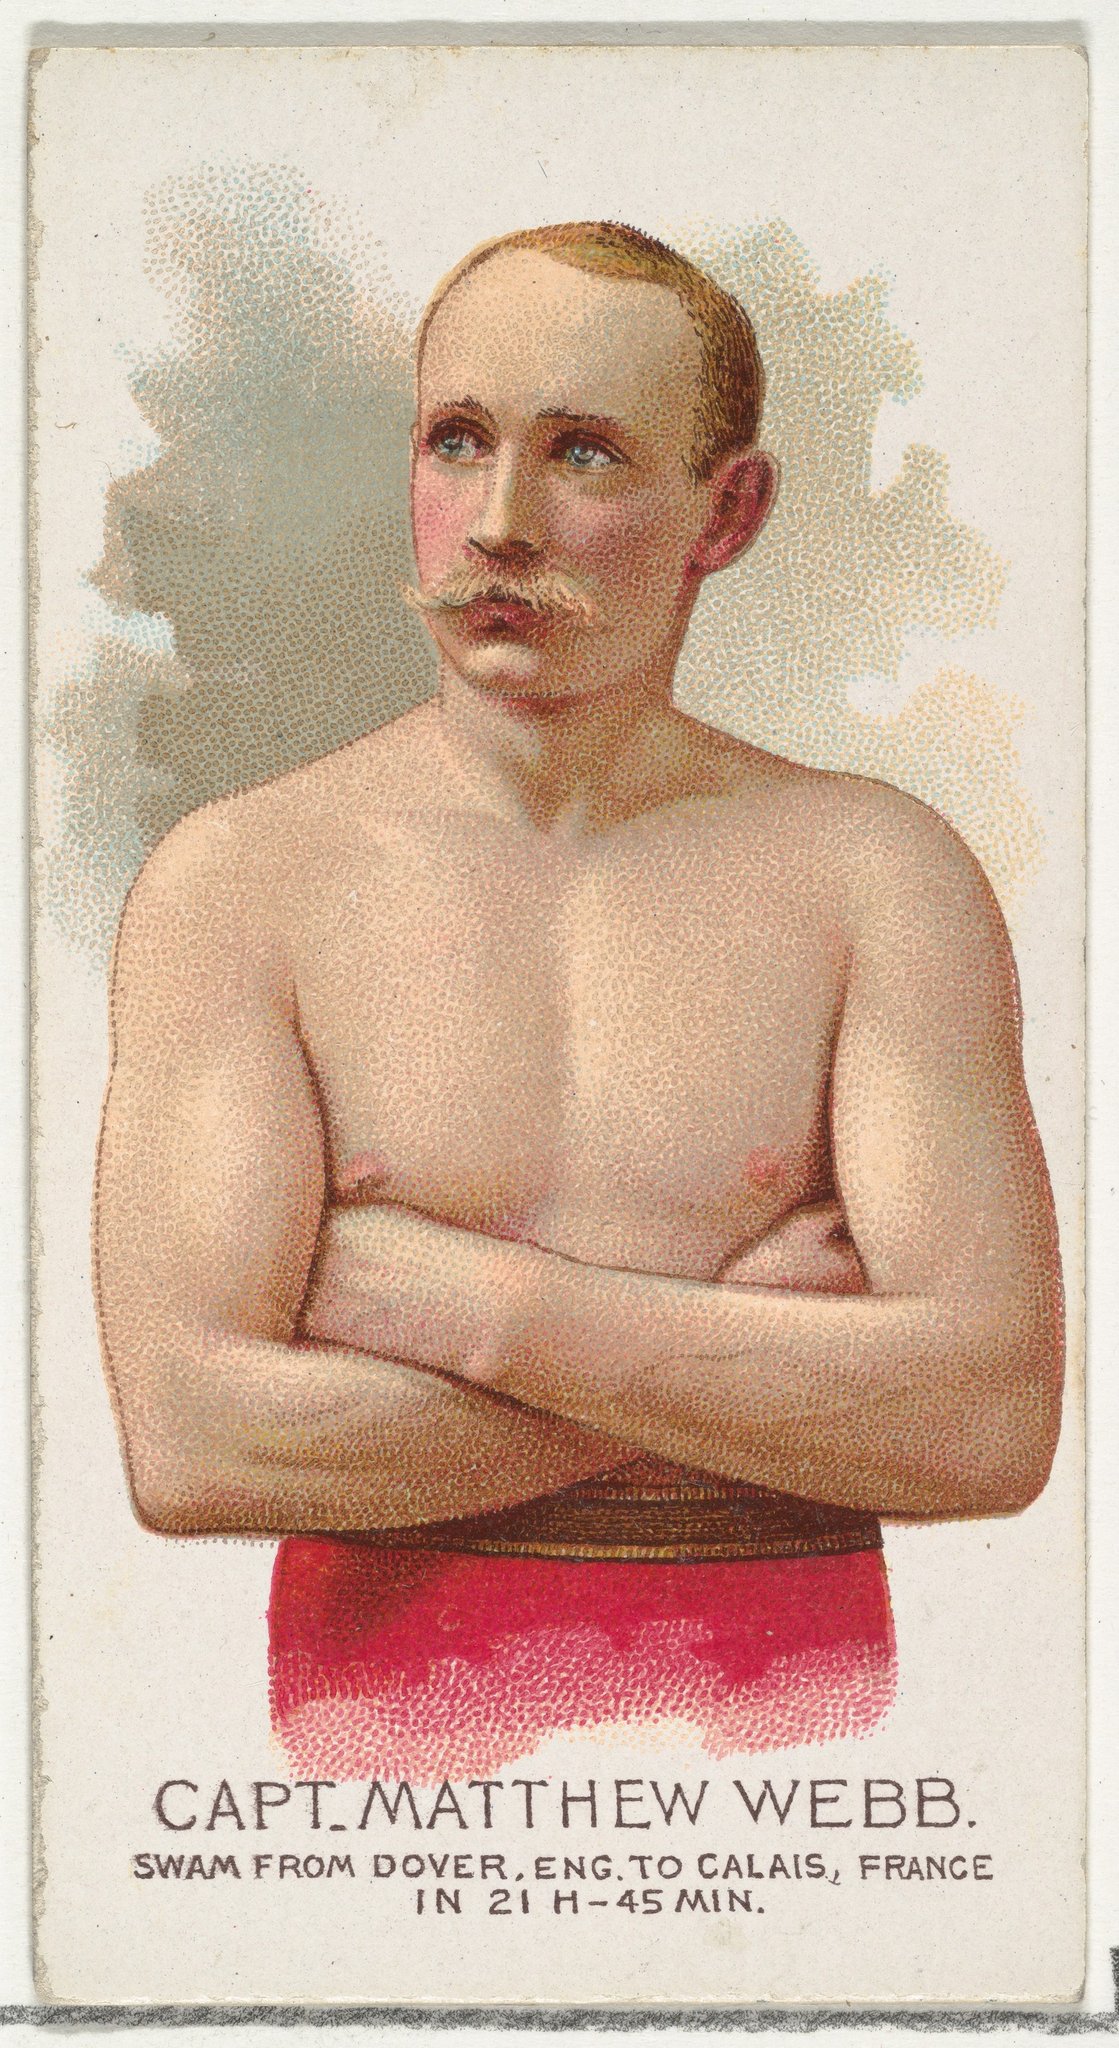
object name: print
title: Captain Matthew Webb, Swam from Dover, England to Calais, France, from World's Champions, Series 2 (N29) for Allen & Ginter Cigarettes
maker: allen & ginter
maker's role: publisher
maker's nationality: american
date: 1888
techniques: color lithograph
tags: men,portraits,athletes